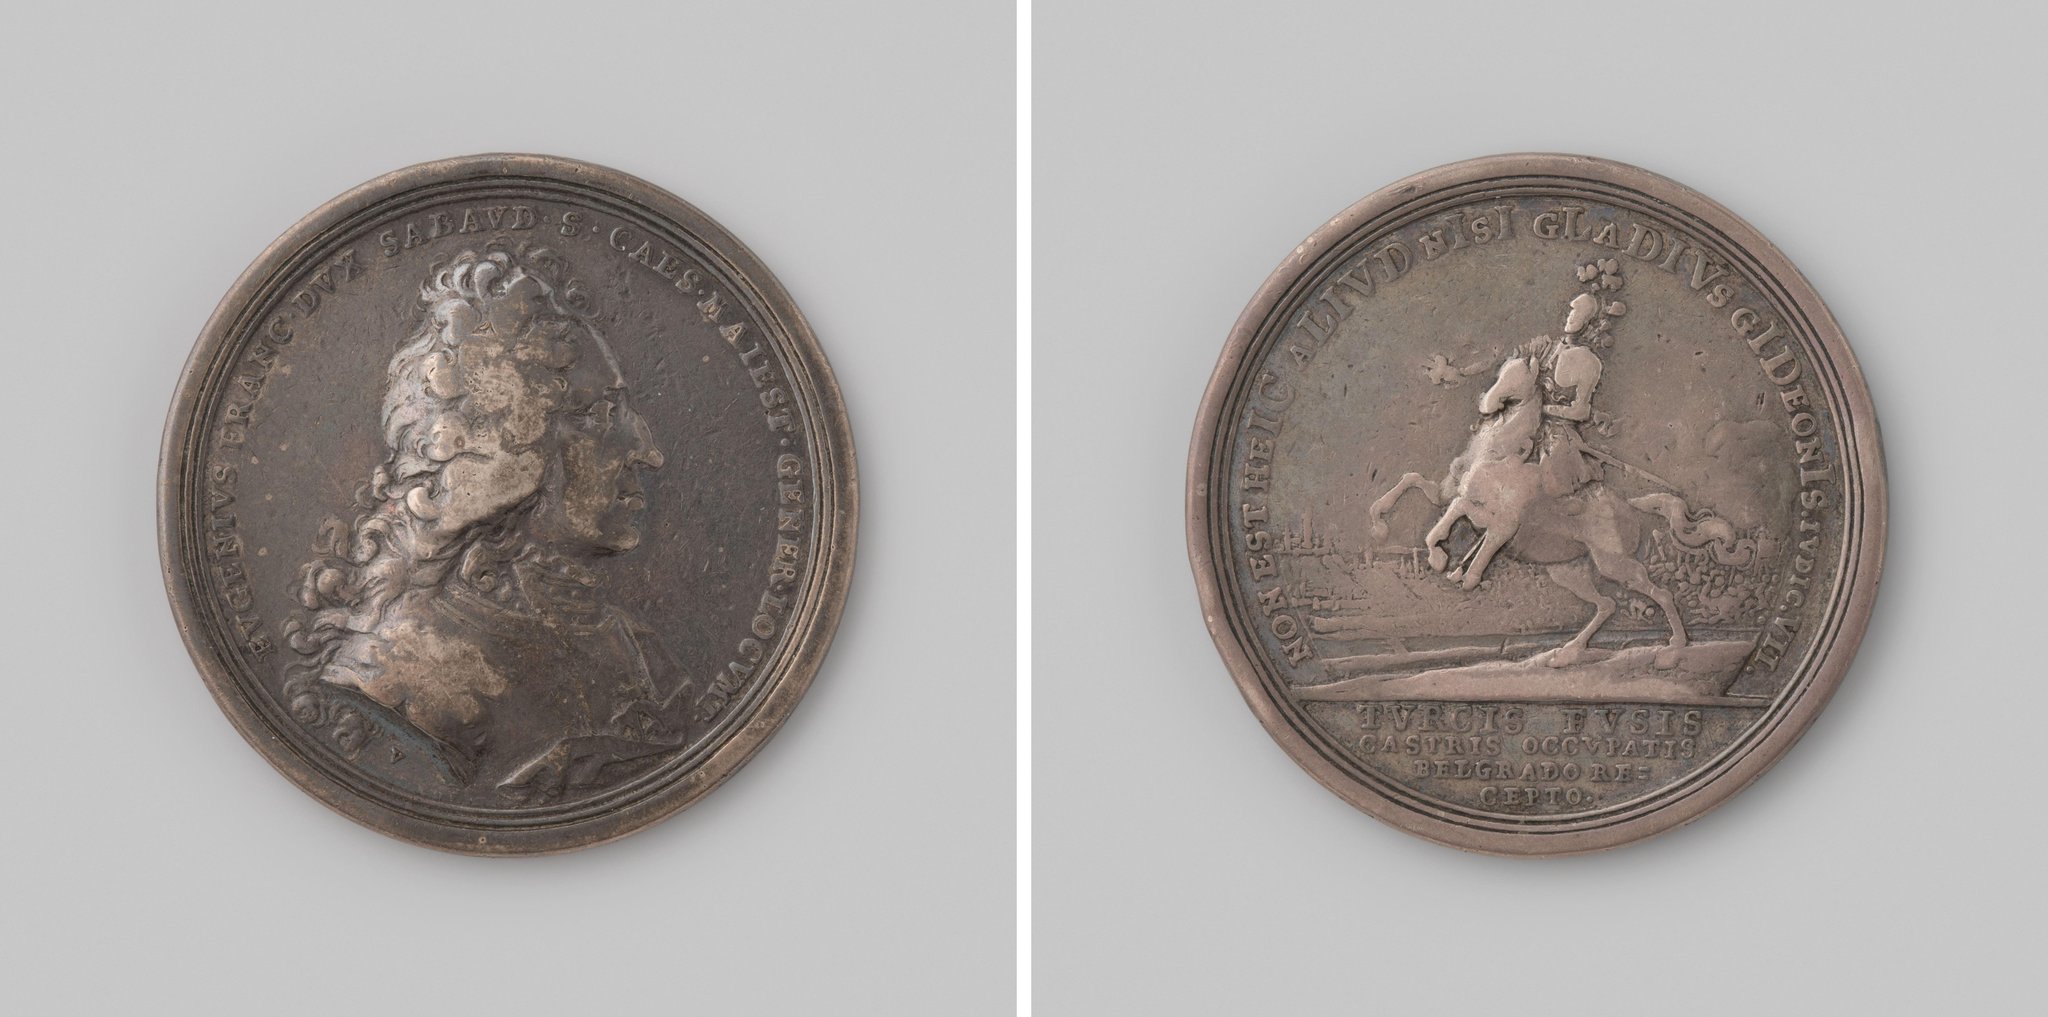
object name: history medal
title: Inname van Belgrado door Eugenius van Savoye 1717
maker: georg wilhelm vestner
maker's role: medailleur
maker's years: 1677-1740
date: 1717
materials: silver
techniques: striking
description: Zilveren penning, op de voorzijde het borstbeeld van Eugenius naar rechts met omschrift, op de keerzijde Eugenius te paard voor Belgrado, met omschrift en afsnedetekst.